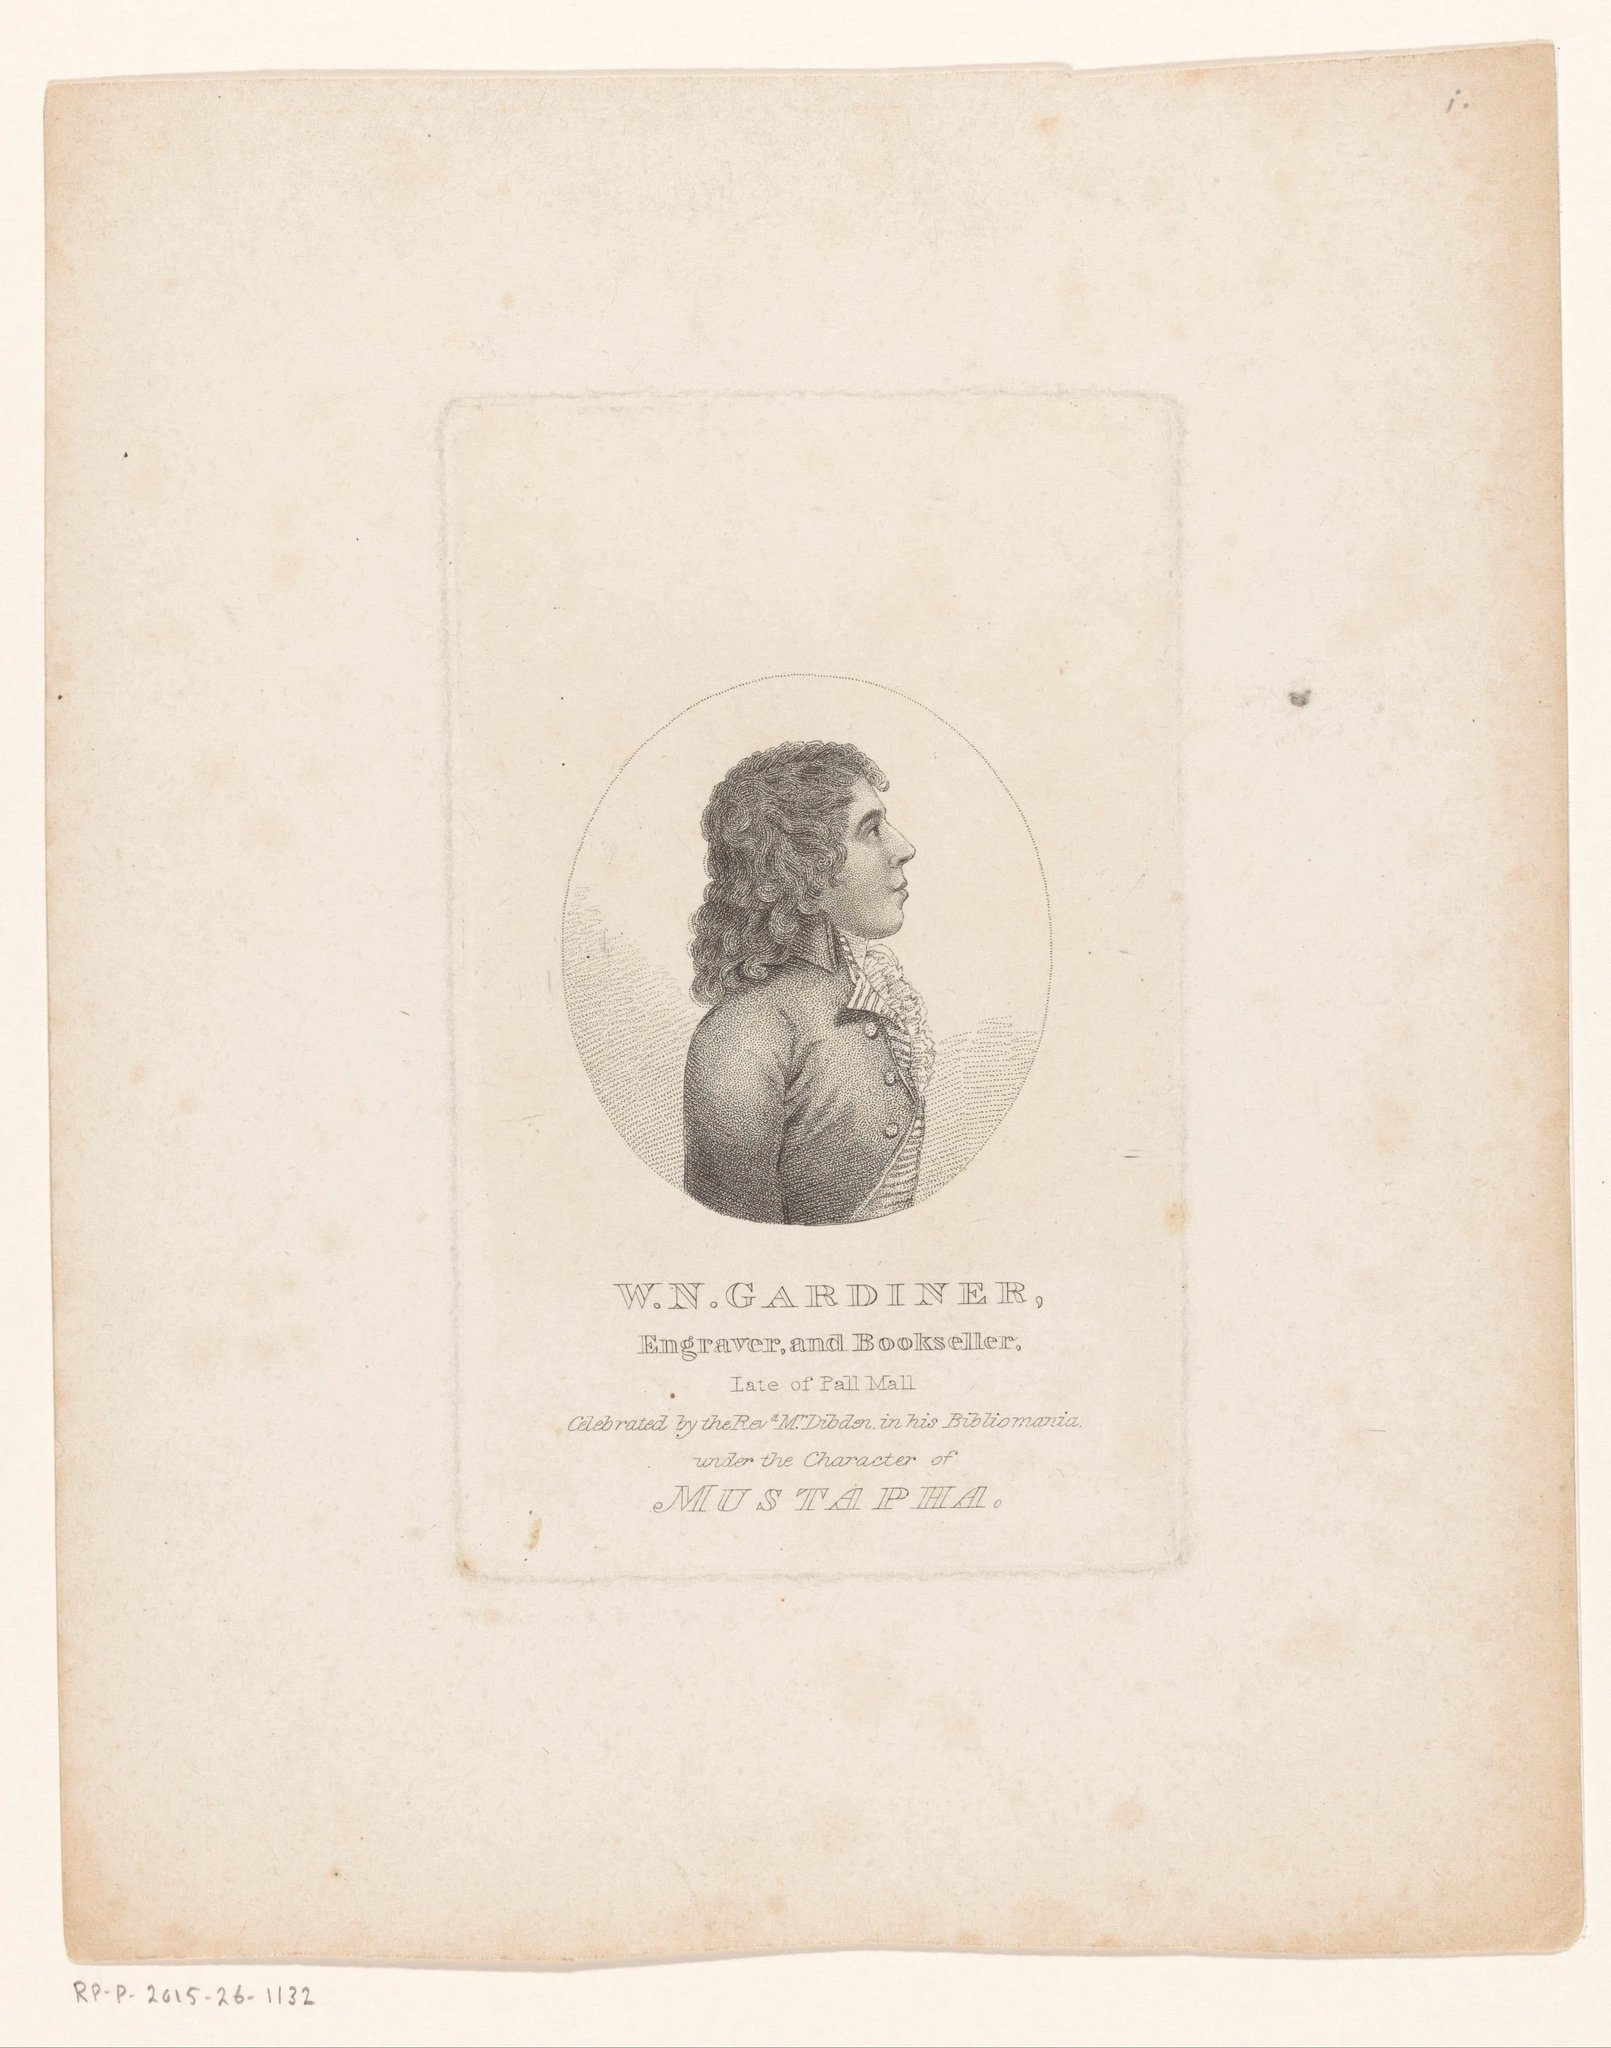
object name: print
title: W.N. Gardiner, Engraver, and Bookseller, Late of Pall Mall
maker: Anonymous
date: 1809-1825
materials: paper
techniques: etching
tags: london, print maker, bookseller, william nelson gardiner, portrait, self-portrait of graphic artist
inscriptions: collector's mark: Lugt 2228